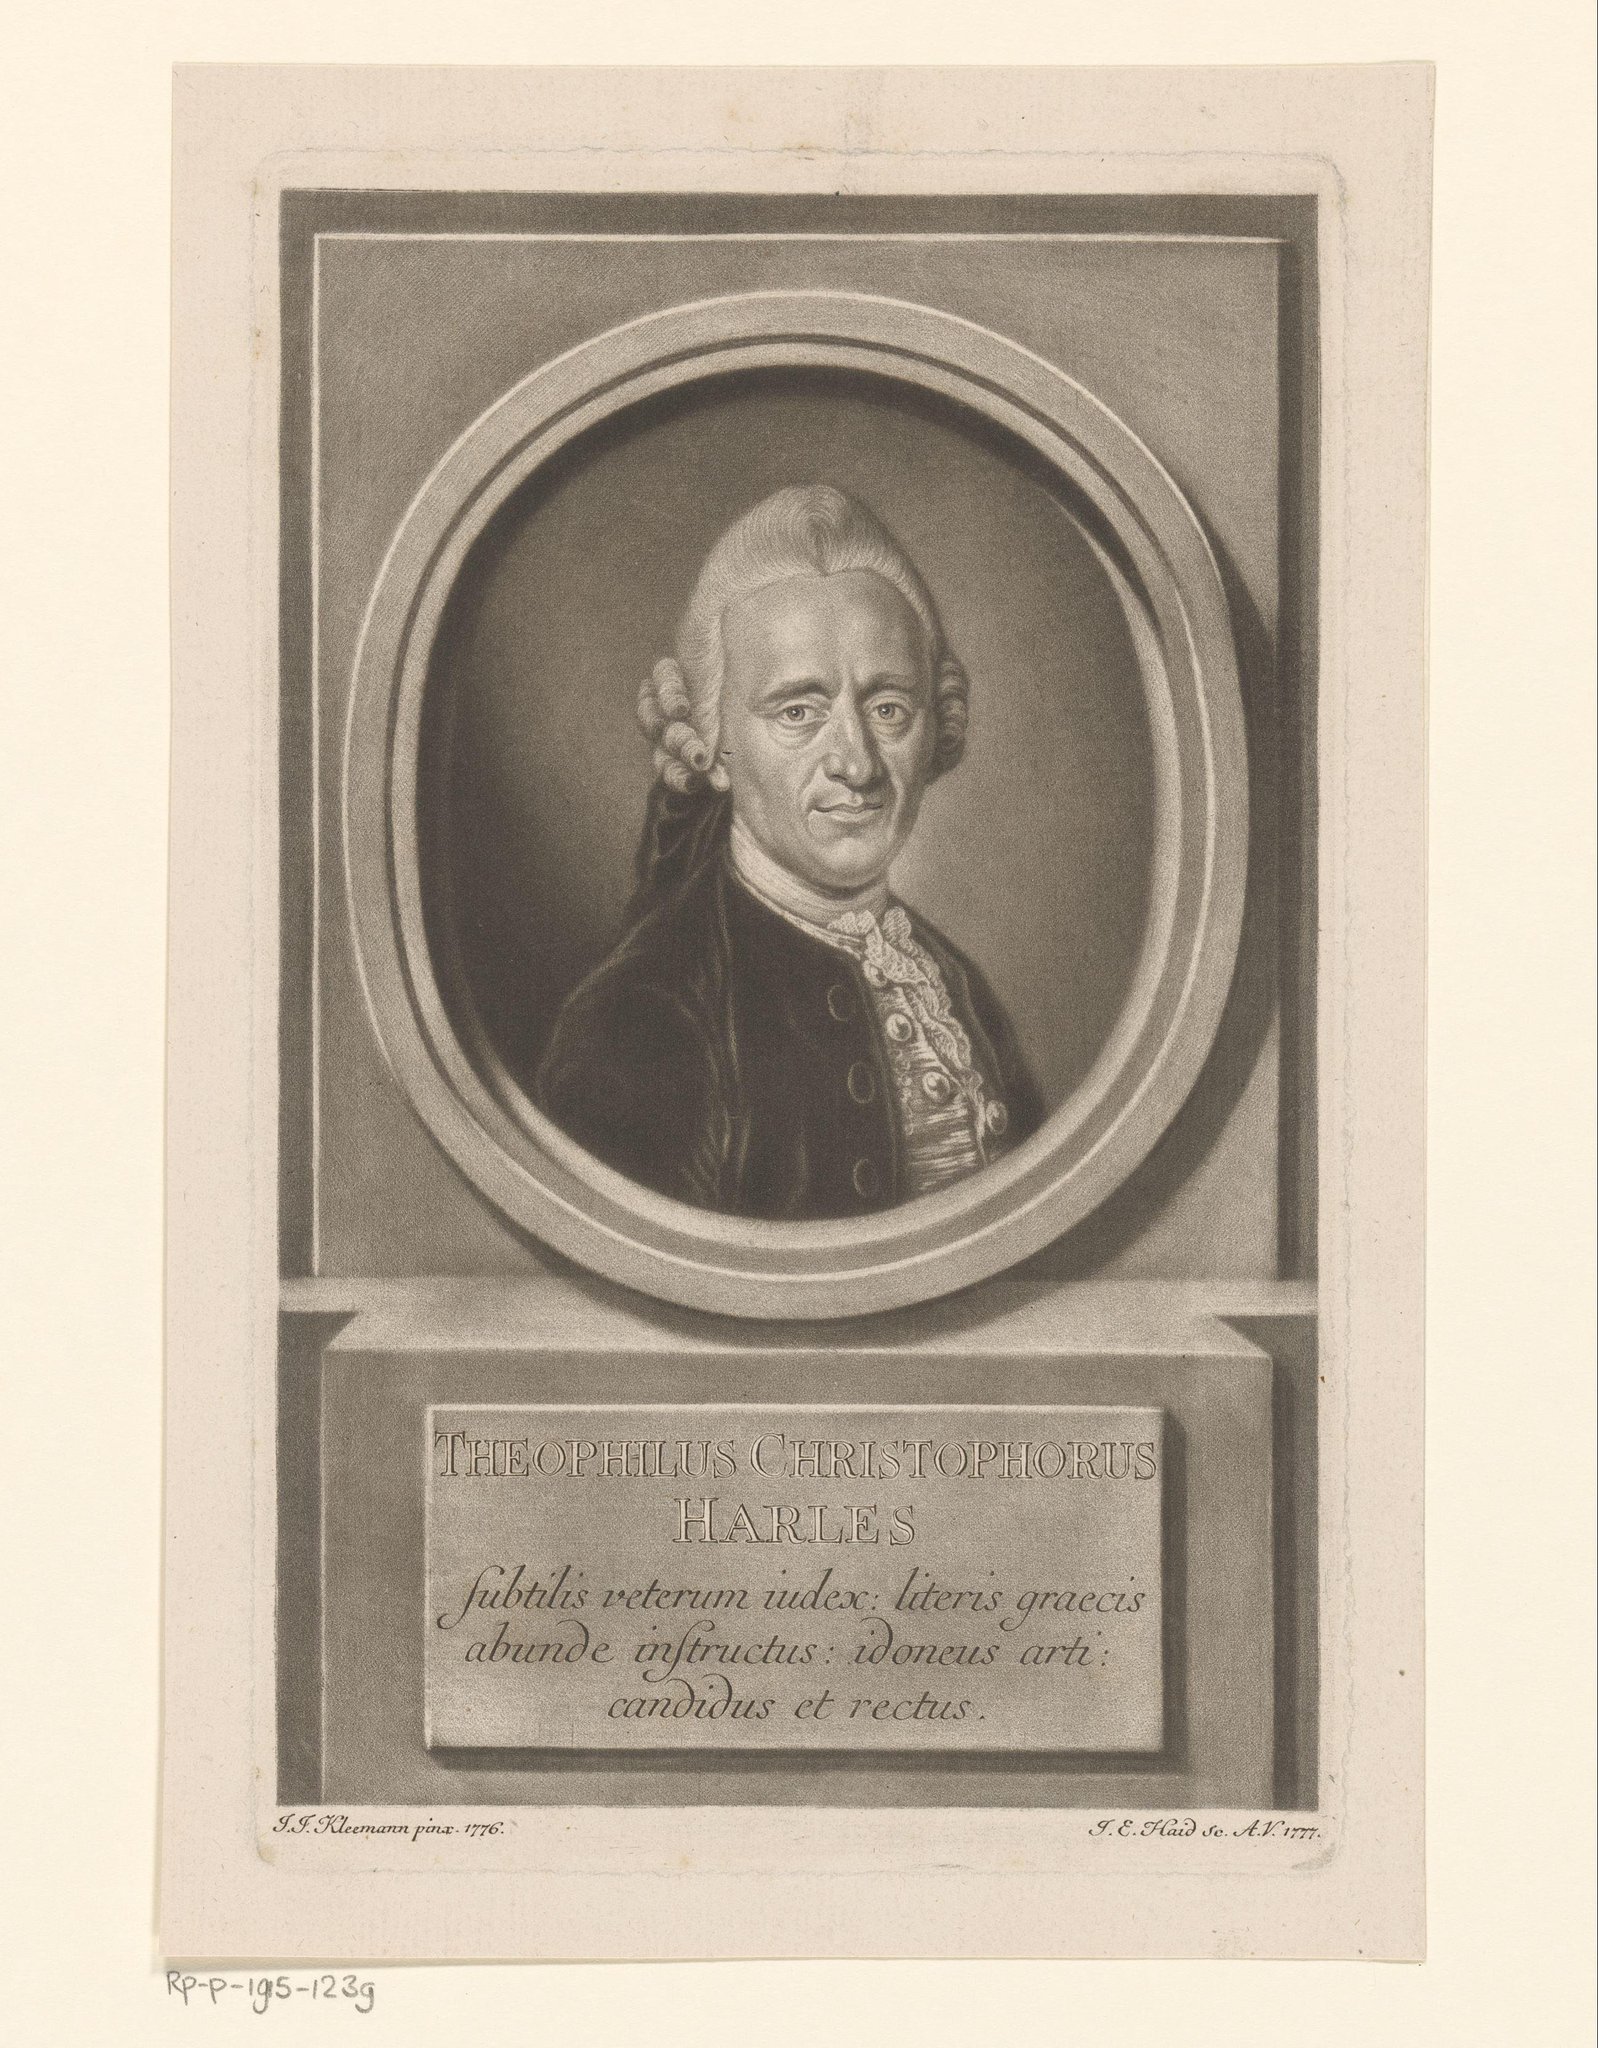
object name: print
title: Portret van Gottlieb Christoph Harles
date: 1776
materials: paper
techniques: mezzotint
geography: augsburg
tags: scholar, philosopher, historical persons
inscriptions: collector's mark: Lugt 2228